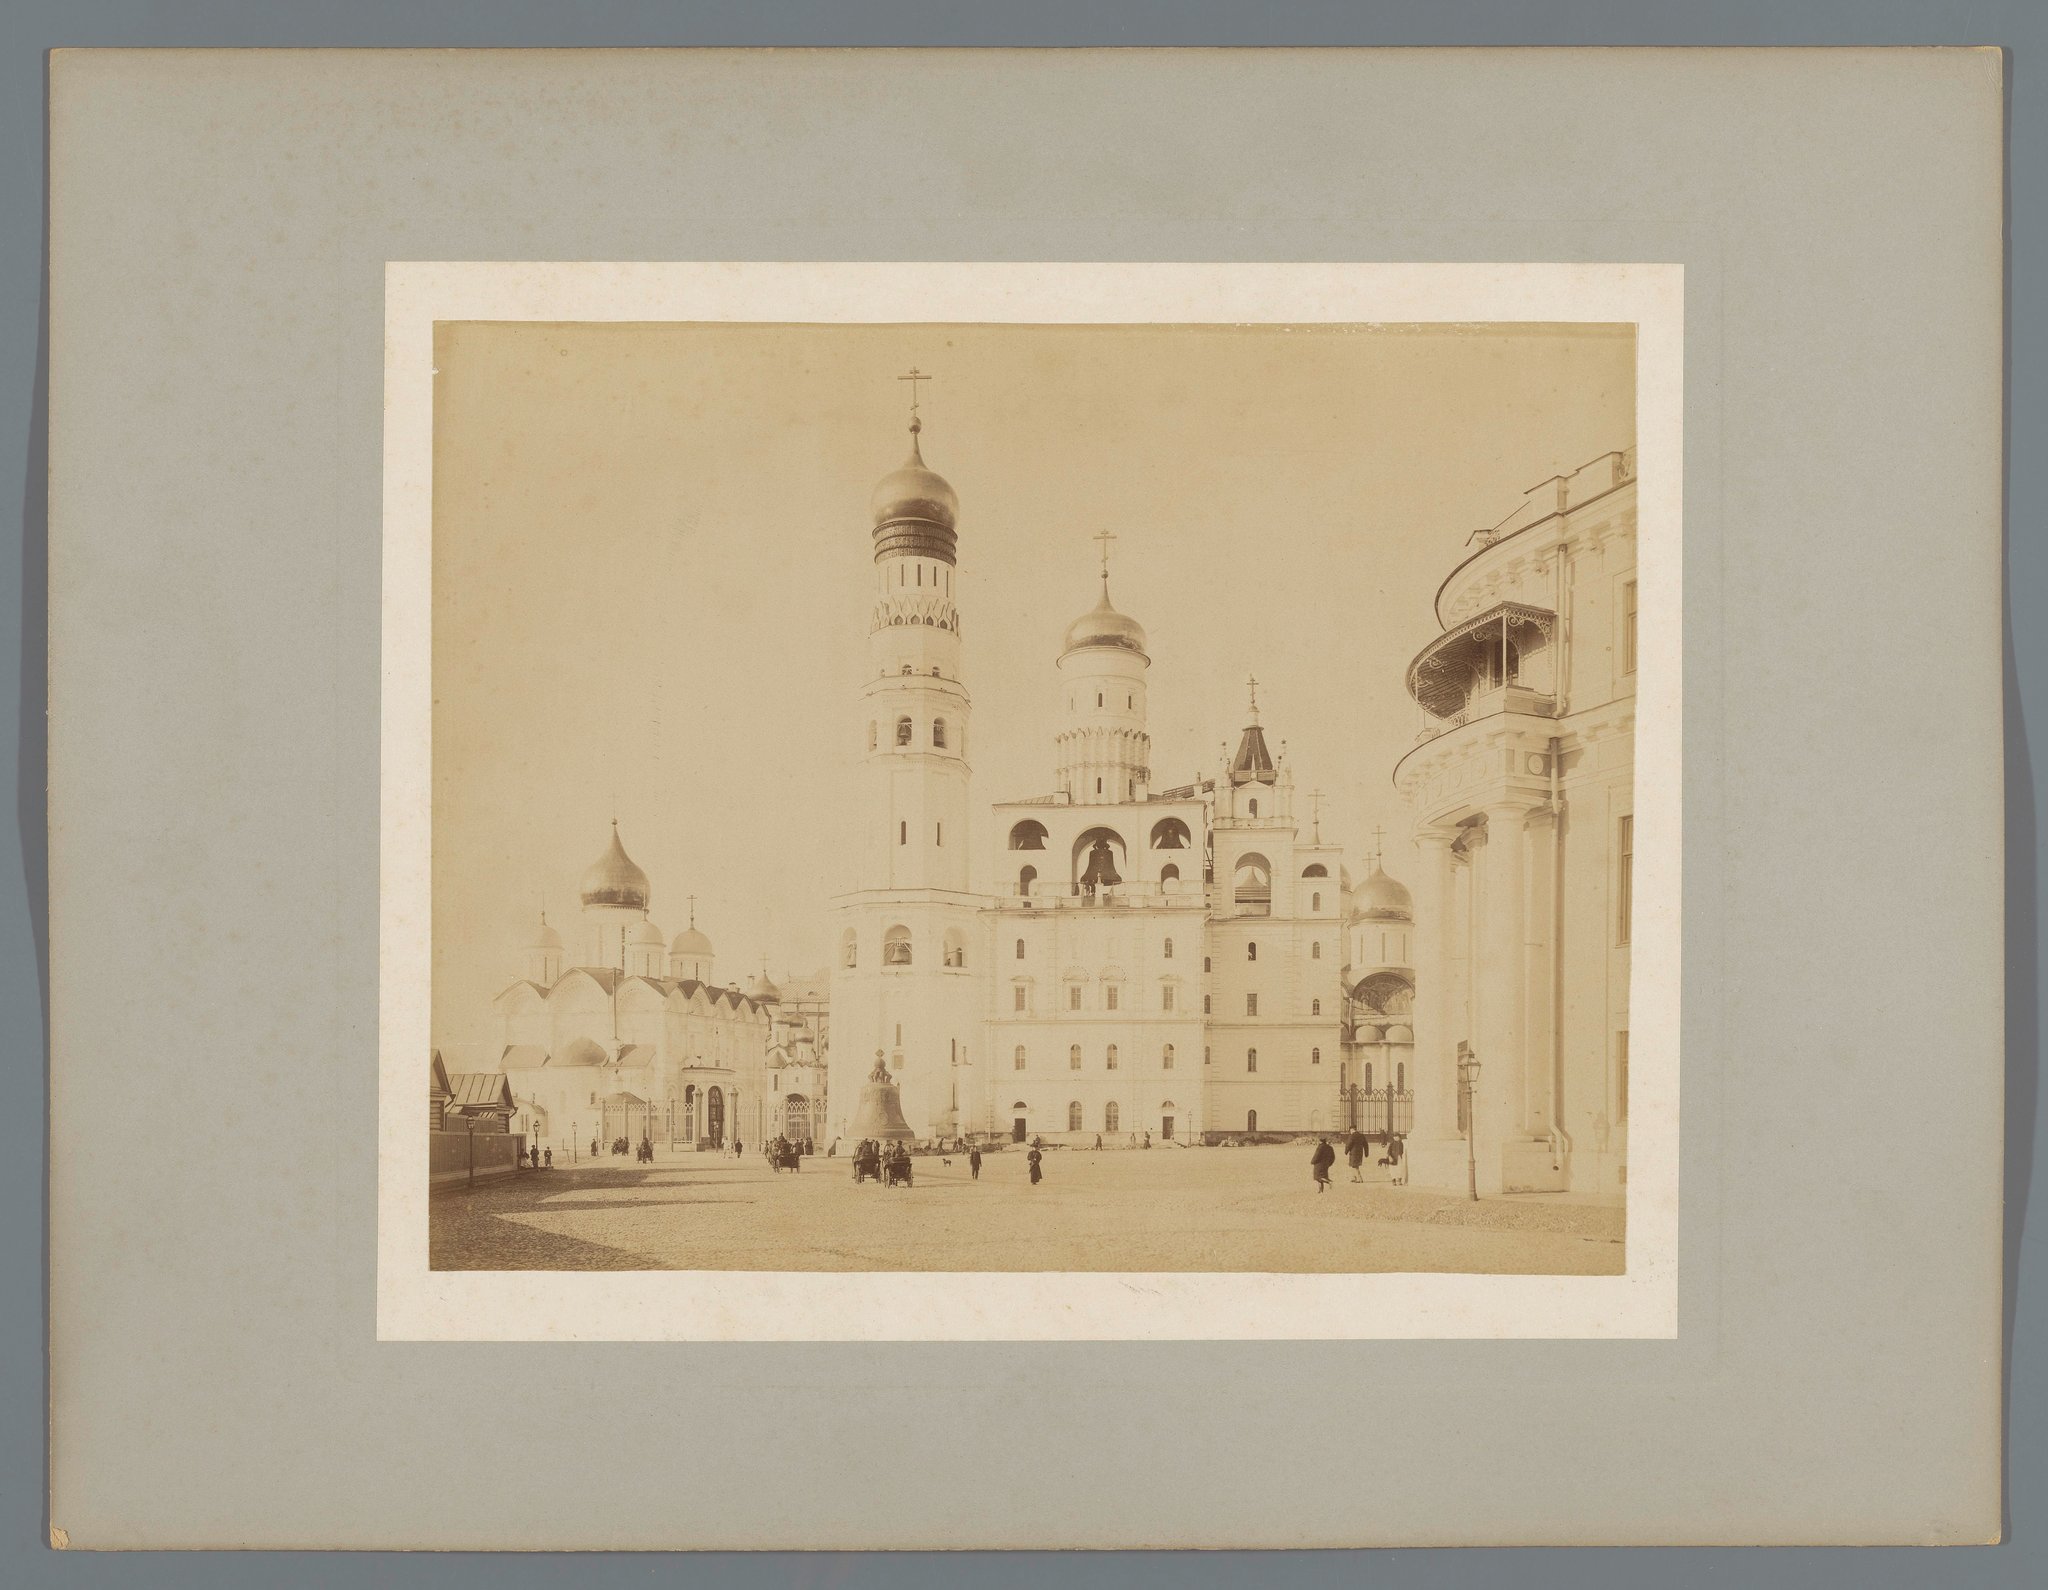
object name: photograph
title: Klokkentoren van Ivan de Grote in het Kremlin van Moskou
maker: Anonymous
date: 1860-1890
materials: cardboard, paper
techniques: albumen print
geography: moscow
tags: parts of church exterior and annexes: campanile